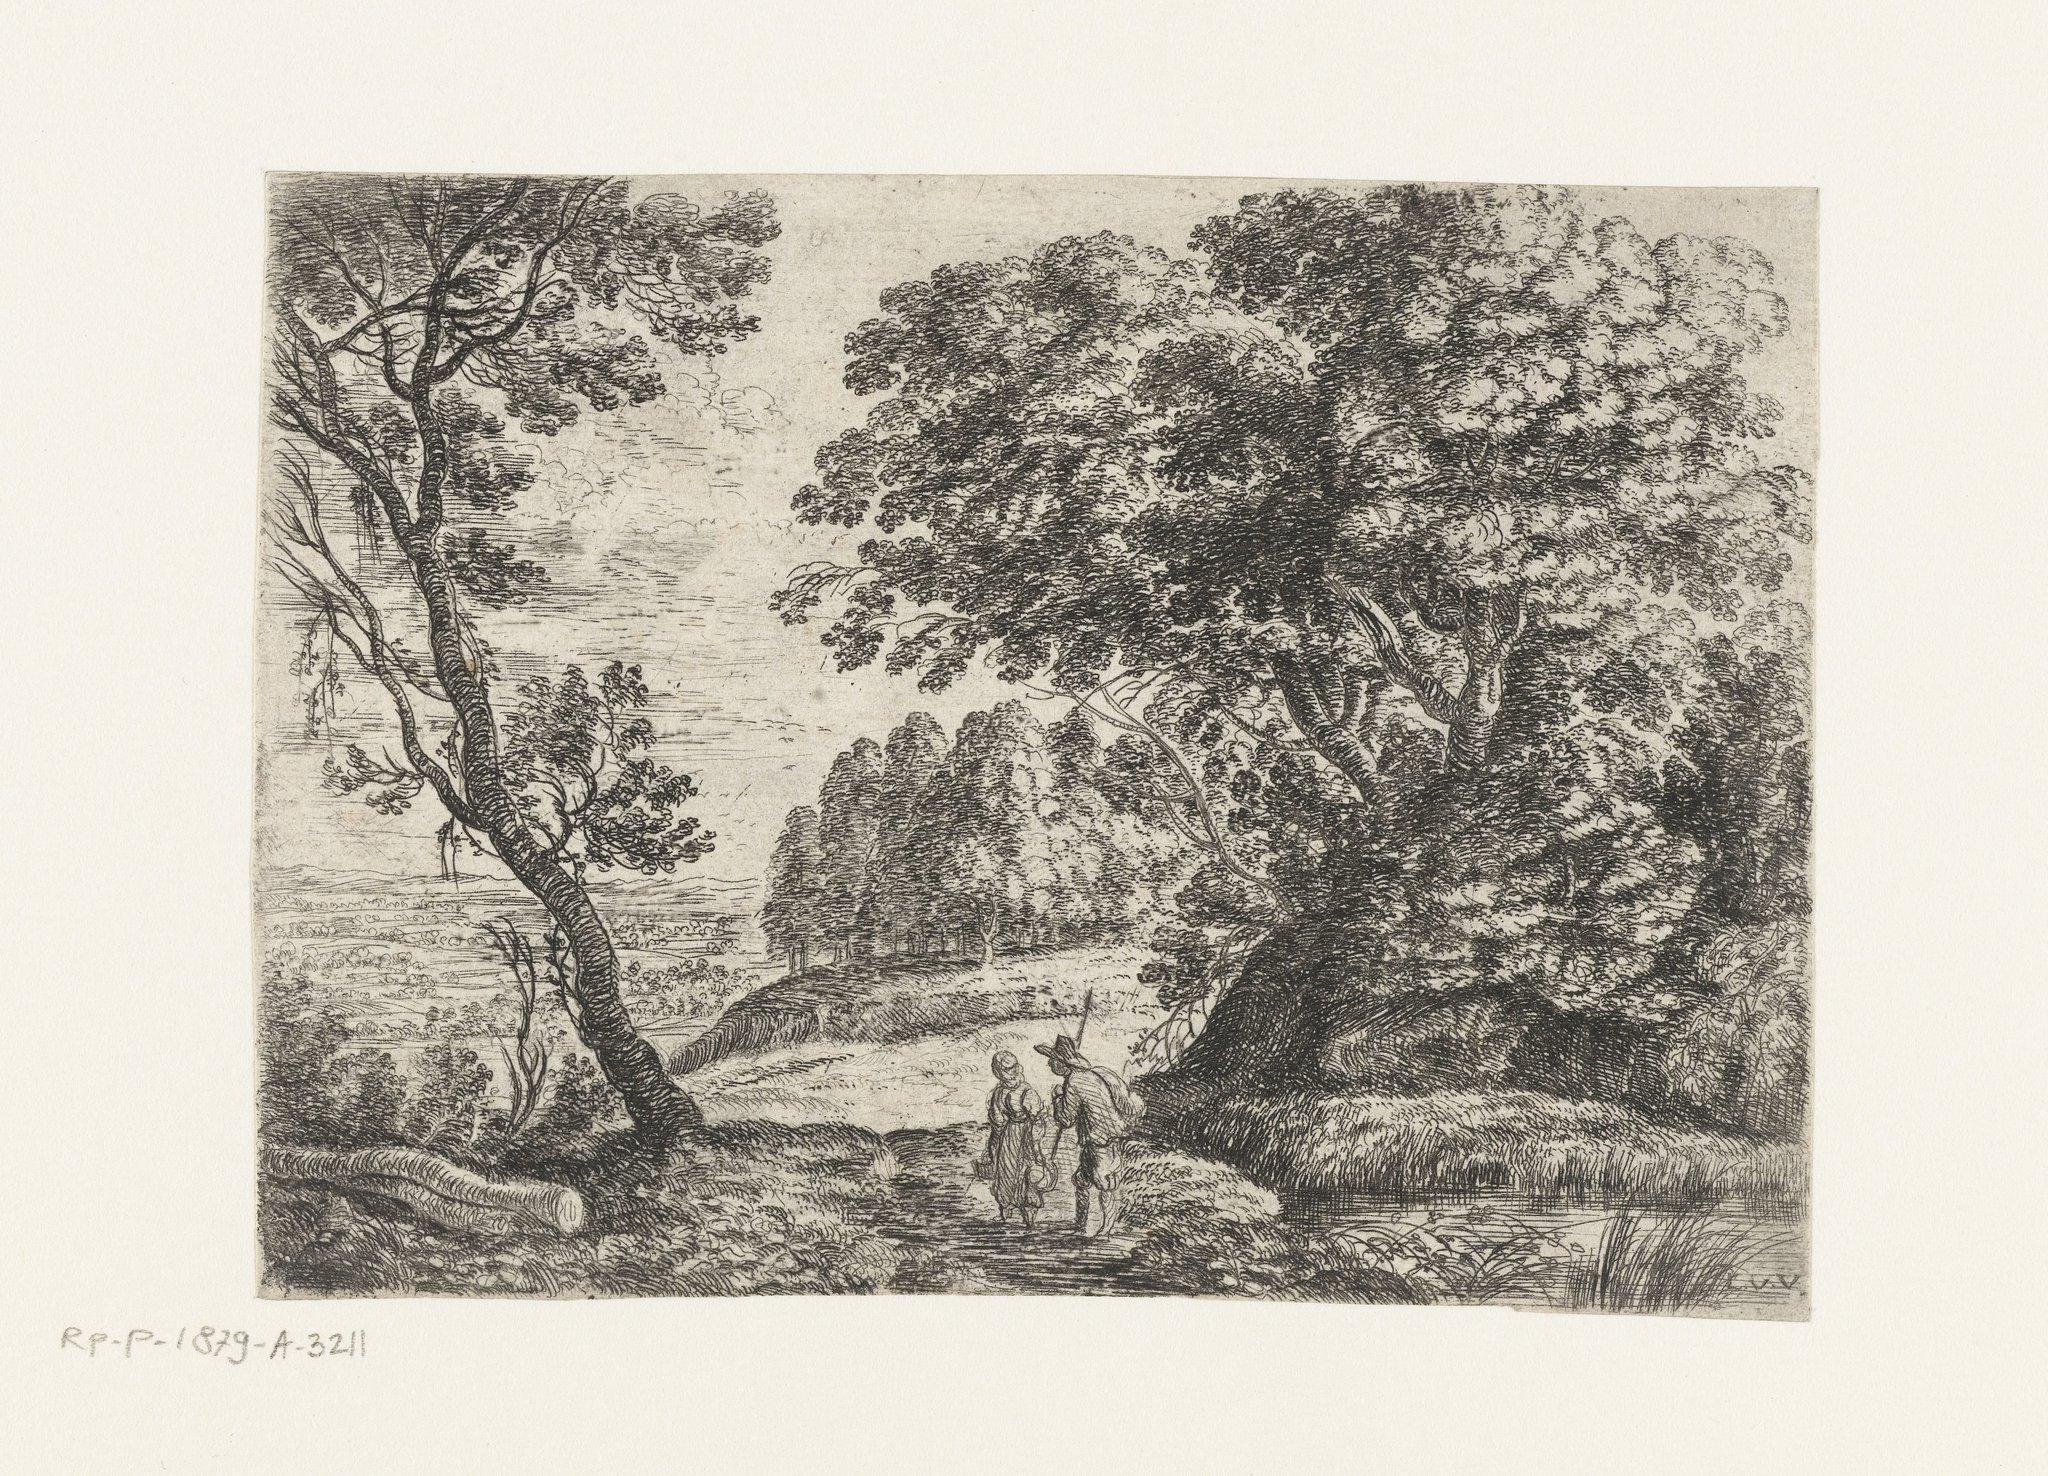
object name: print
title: Landschap met een man en vrouw in gesprek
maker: lucas van uden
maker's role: draughtsman, print maker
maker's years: 1595-1673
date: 1605-1673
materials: paper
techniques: engraving, etching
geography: low countries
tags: landscapes in the temperate zone, female sex; woman, male sex; man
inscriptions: collector's mark: Lugt 2228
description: Uit een serie van zes. Bosachtig landschap met een man en een vrouw in gesprek.